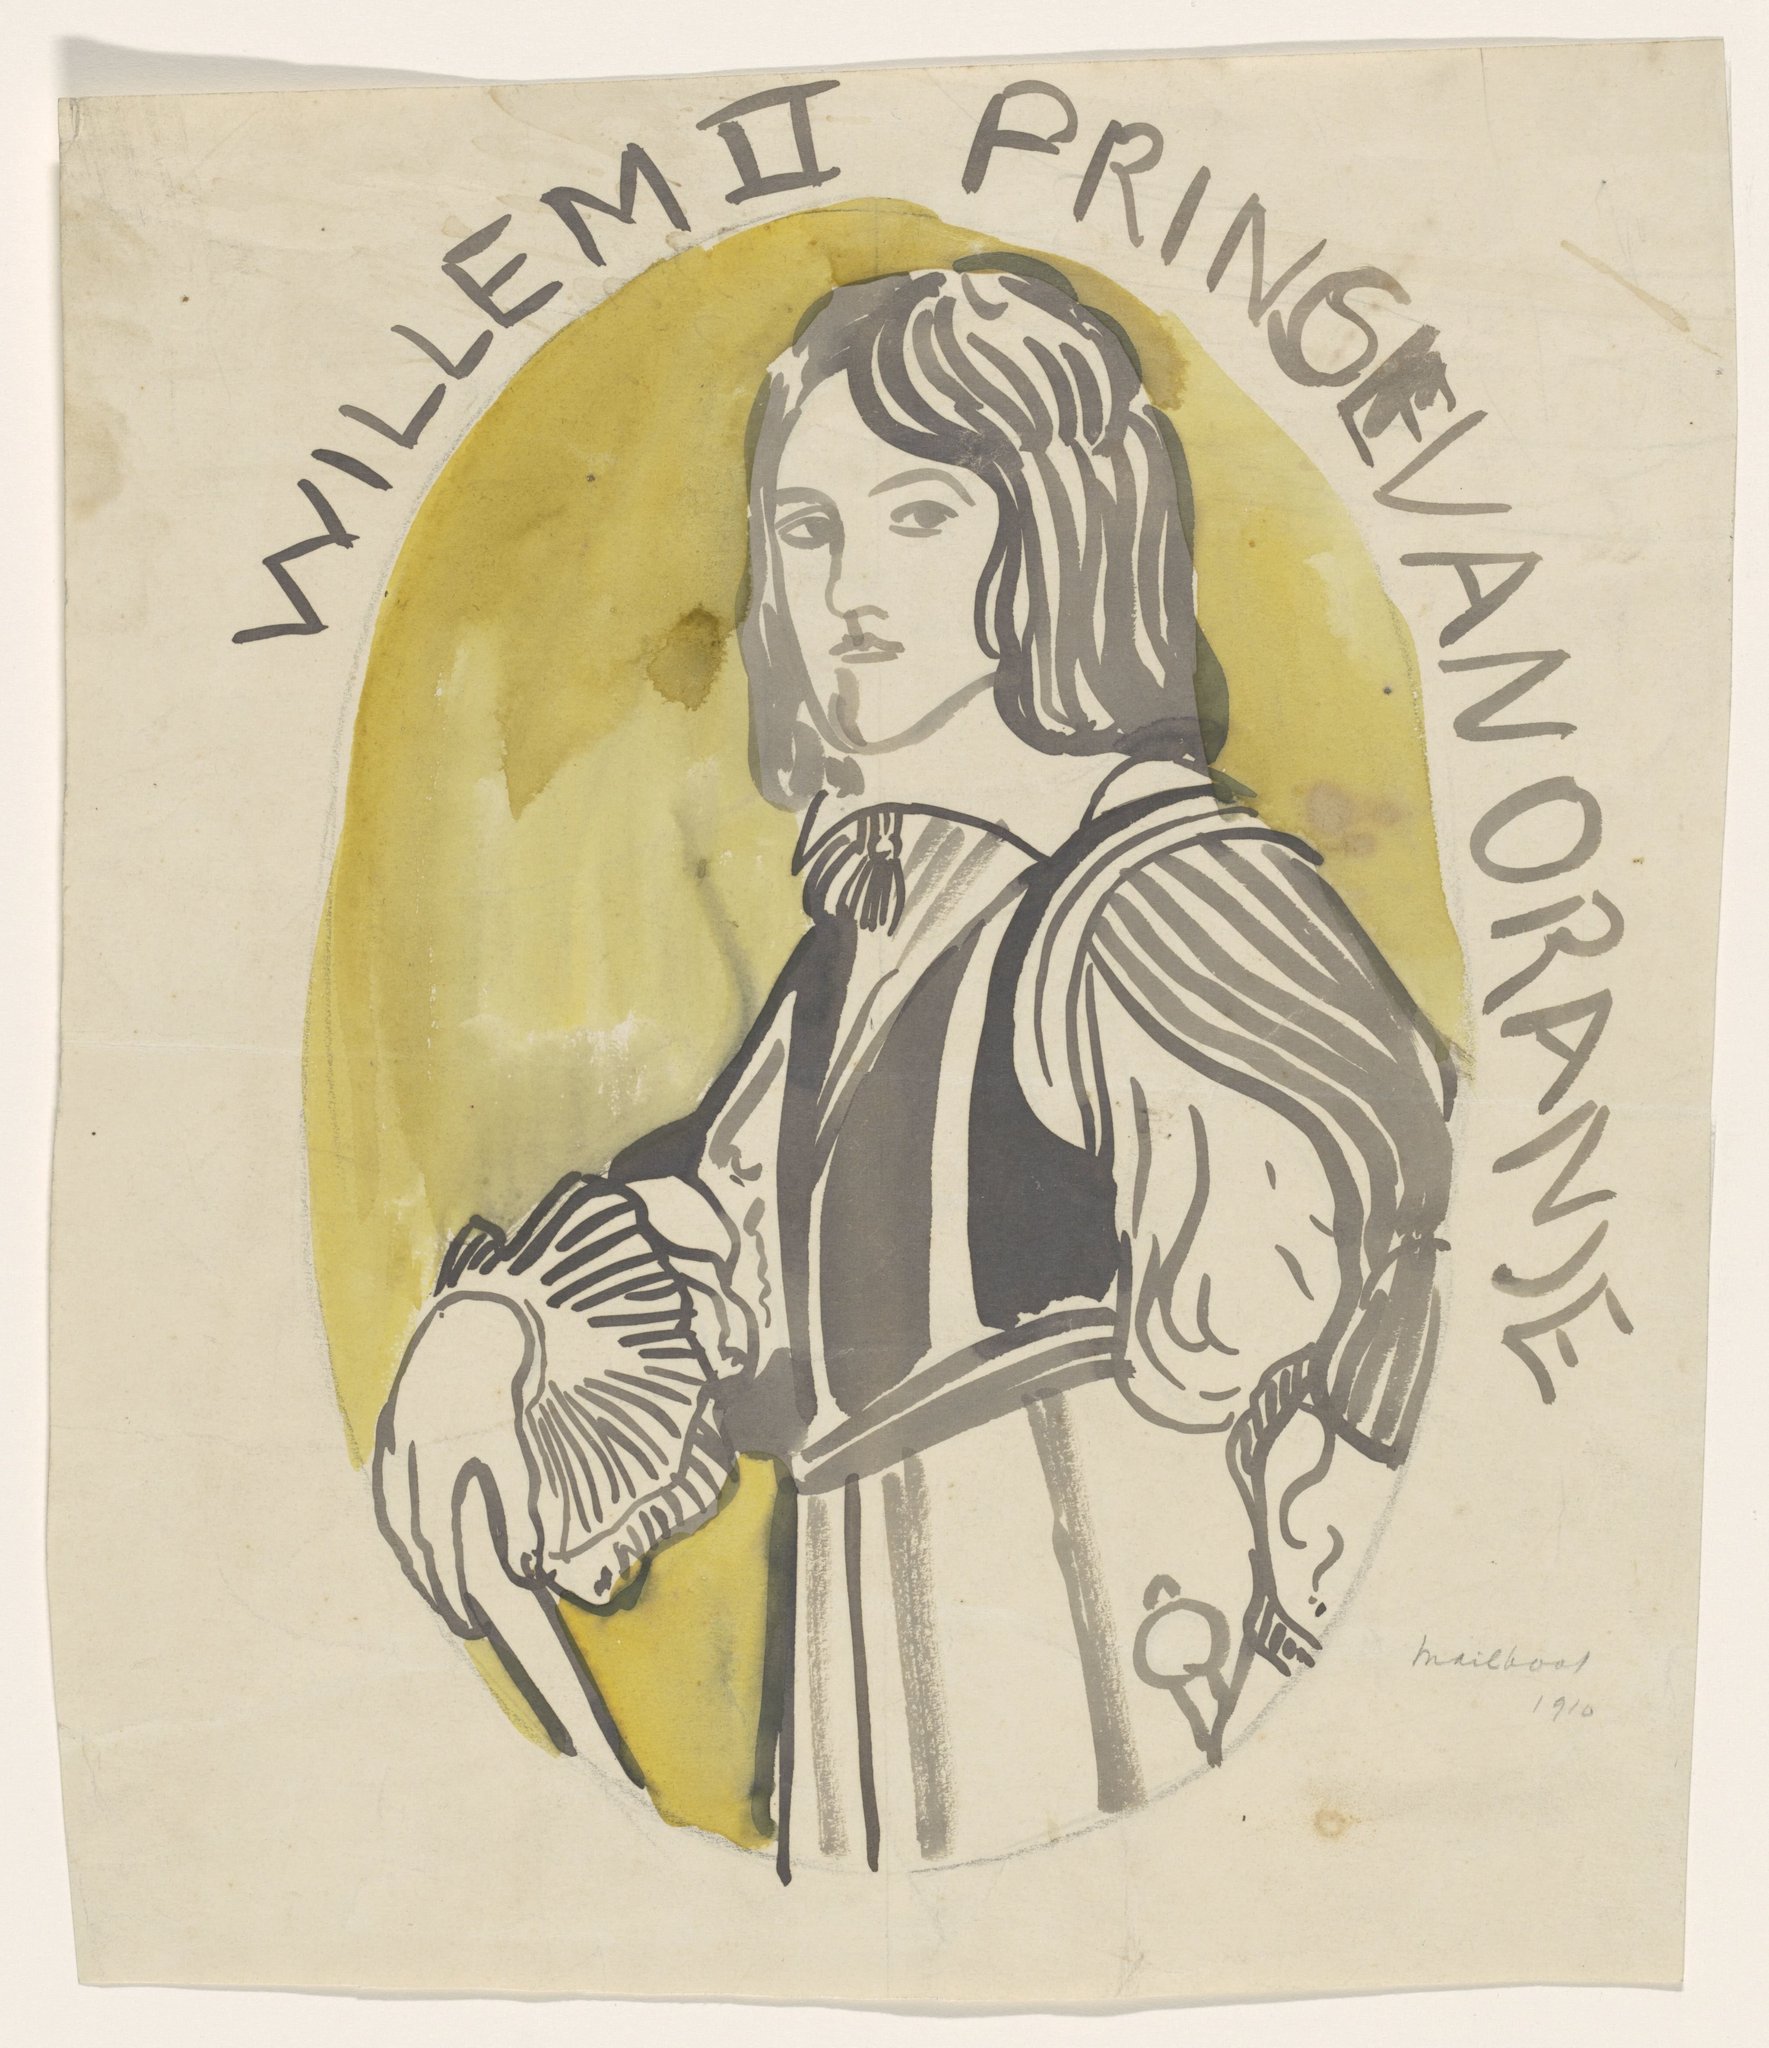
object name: design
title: Ontwerp voor een schildering in de Mailboot: Willem II Prins van Oranje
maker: carel adolph lion cachet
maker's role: draughtsman, print maker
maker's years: 1864-1945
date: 1874-1945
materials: chalk, paper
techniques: brush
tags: william ii (prince of orange), historical persons